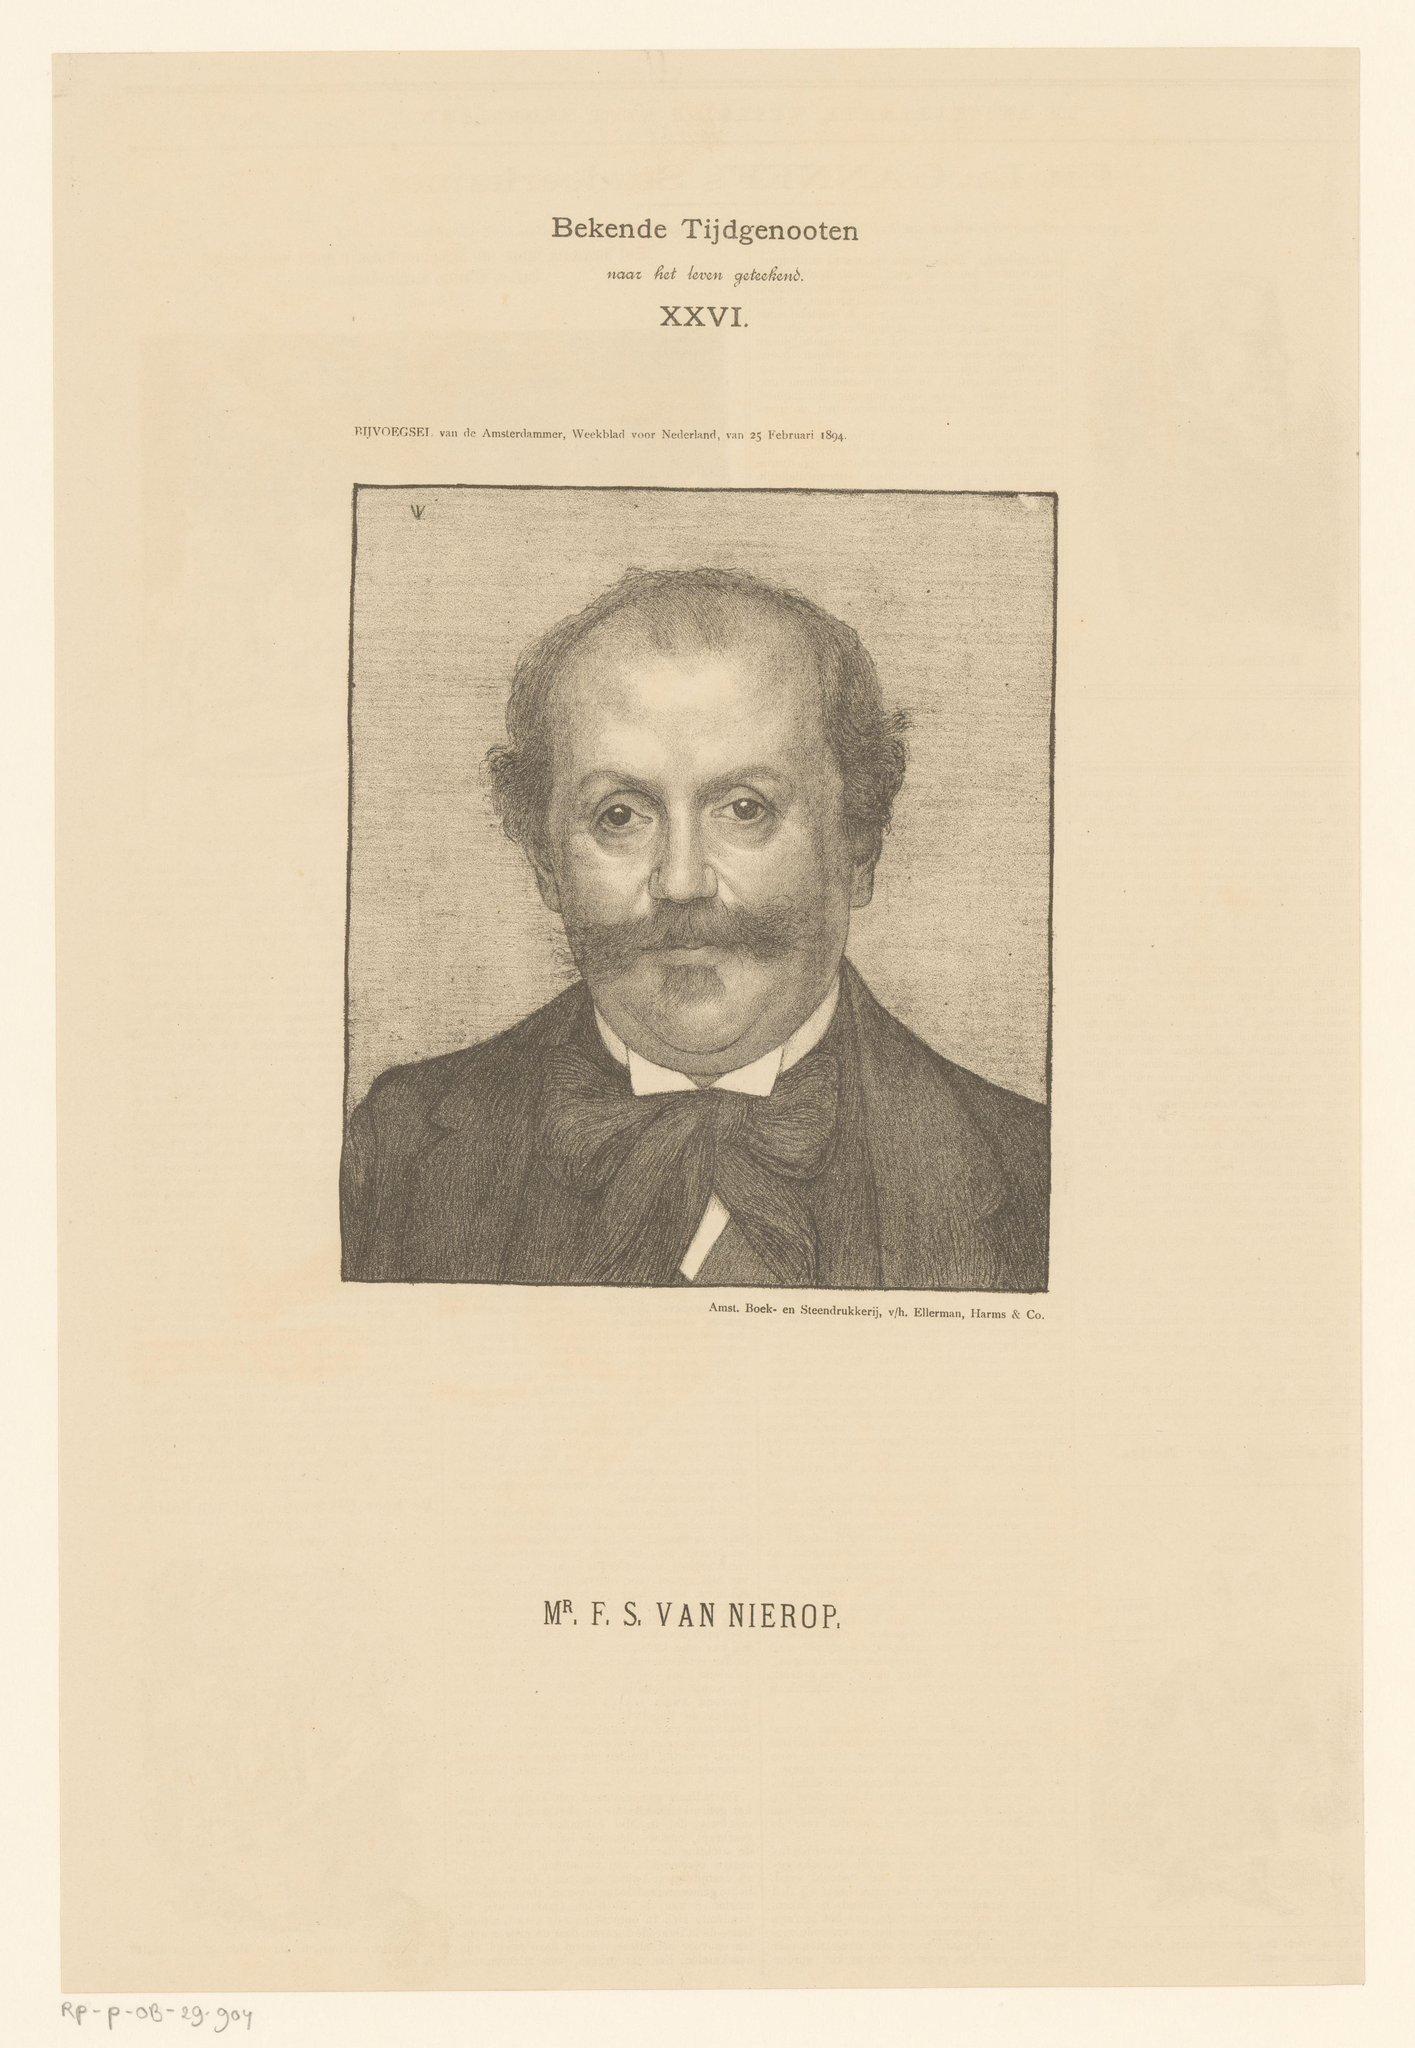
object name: print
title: Portret van Frederik Salomon van Nierop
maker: jan veth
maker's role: designer, draughtsman, painter, print maker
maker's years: 1864-1925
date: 1894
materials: paper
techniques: lithograph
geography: amsterdam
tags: amsterdam, historical persons (+ (full) bust portrait)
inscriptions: collector's mark: Lugt 2228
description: Deze prent werd uitgegeven als bijvoegsel van De Amsterdammer op 25 februari 1894.